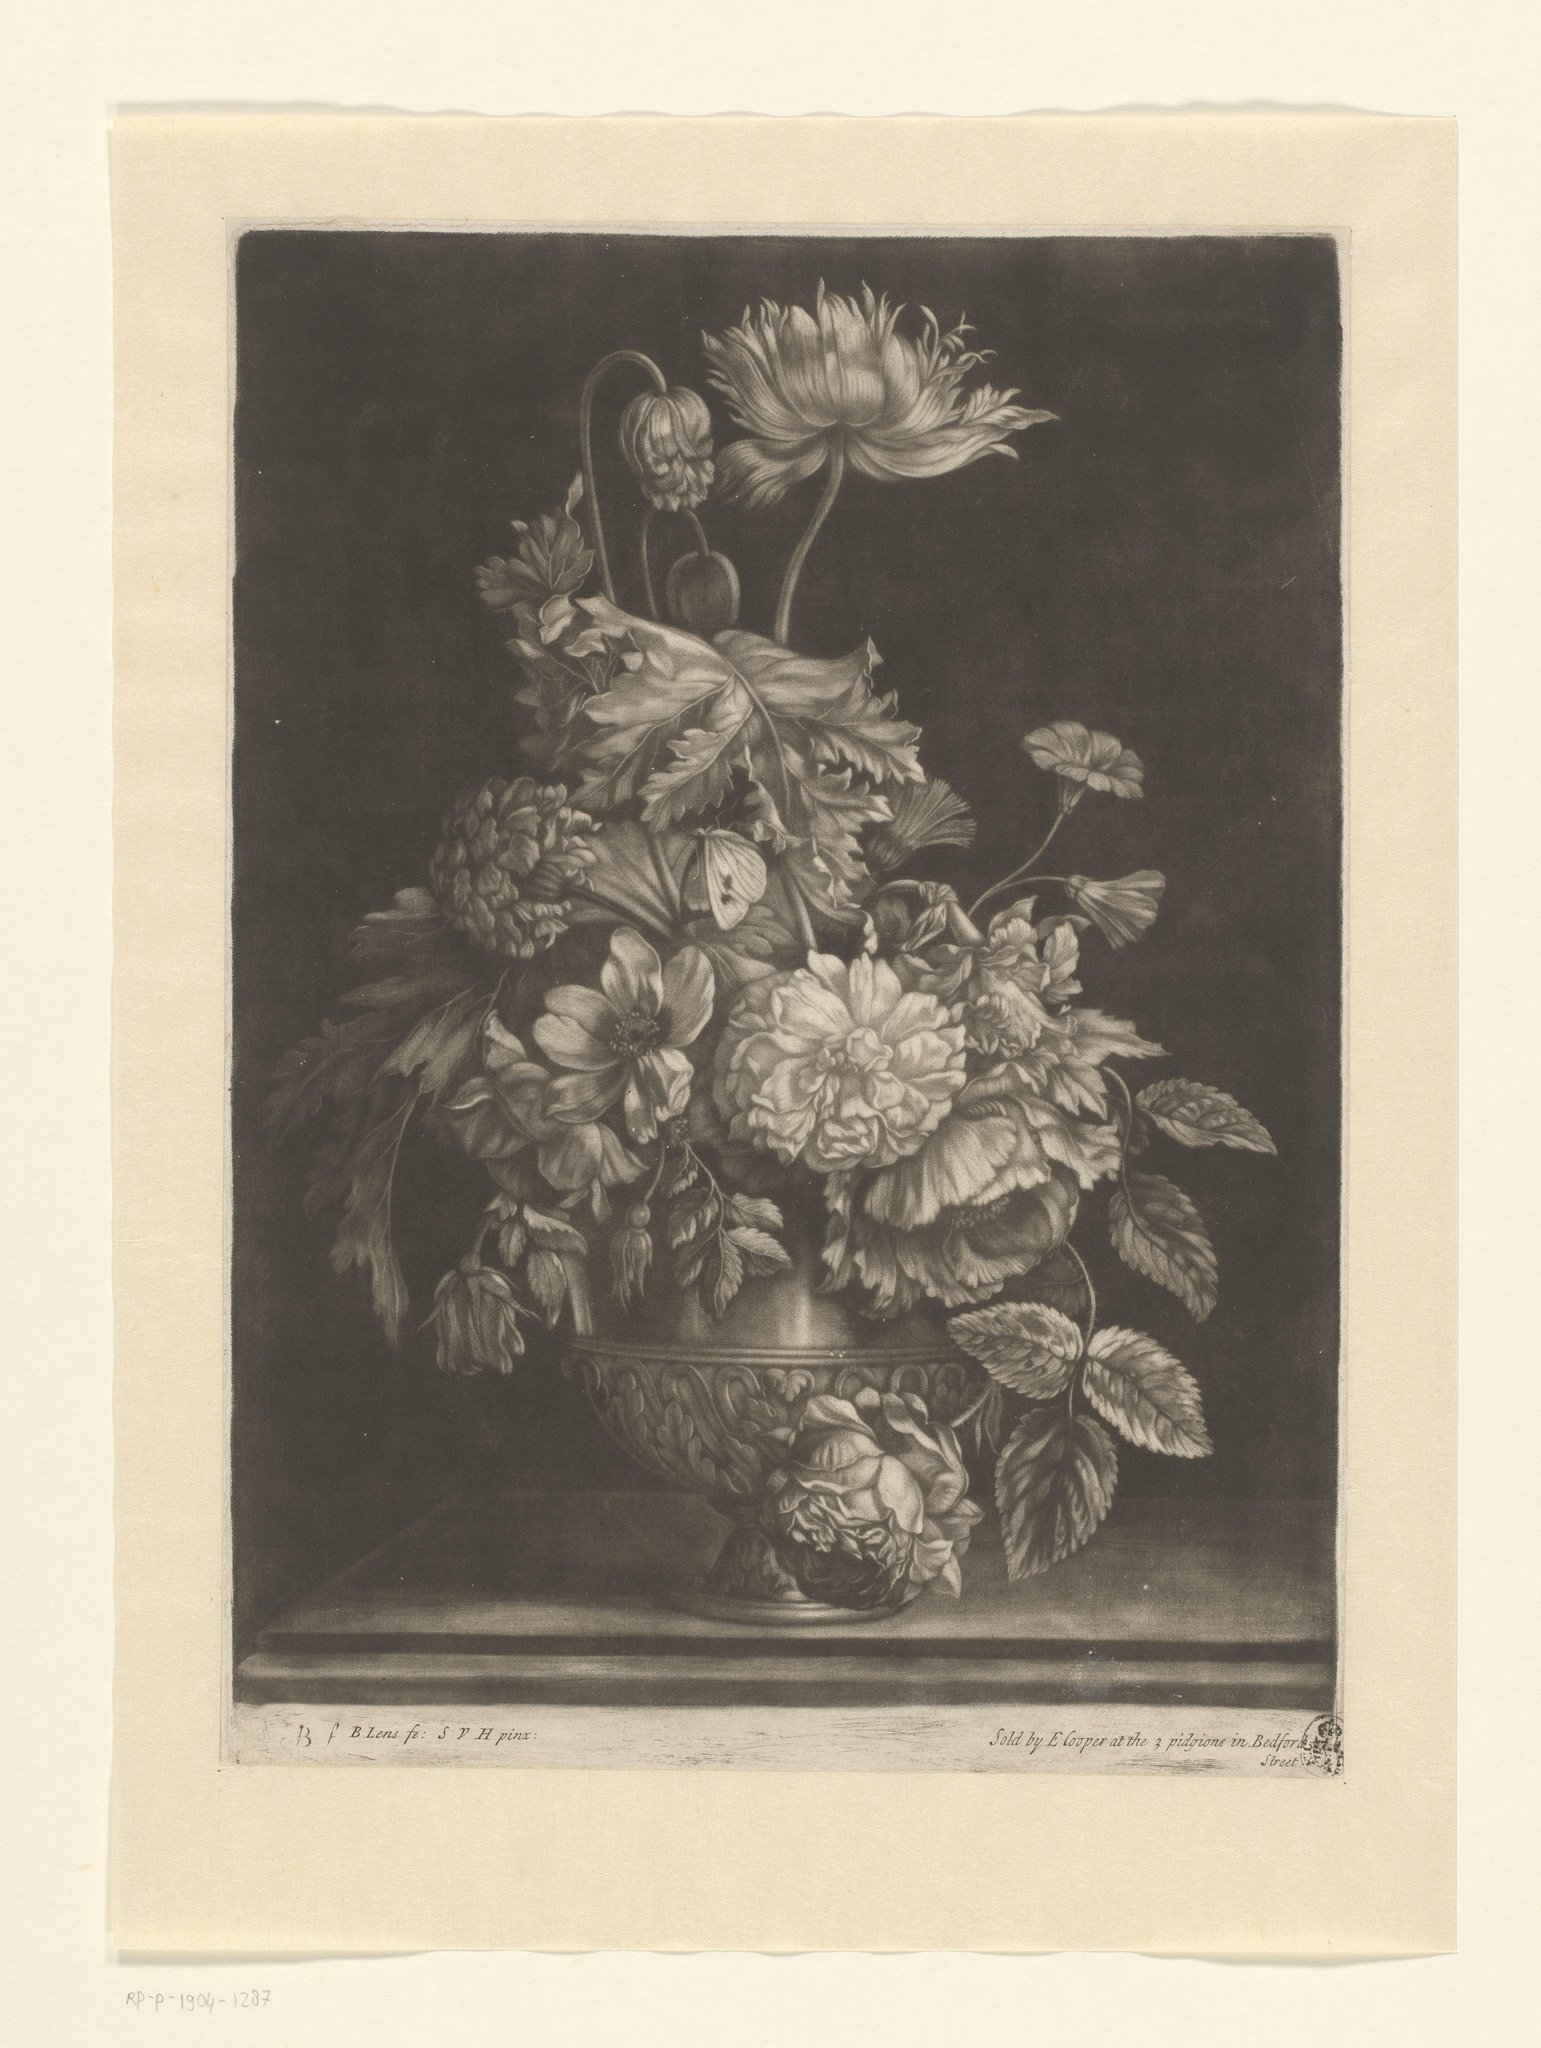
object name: print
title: Vaas met bloemen en een vlinder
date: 1682-1725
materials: paper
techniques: mezzotint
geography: london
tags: flowers, insects: butterfly, flowers in a vase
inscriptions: collector's mark: Lugt 1647, collector's mark: Lugt 291b, collector's mark: Lugt 2228